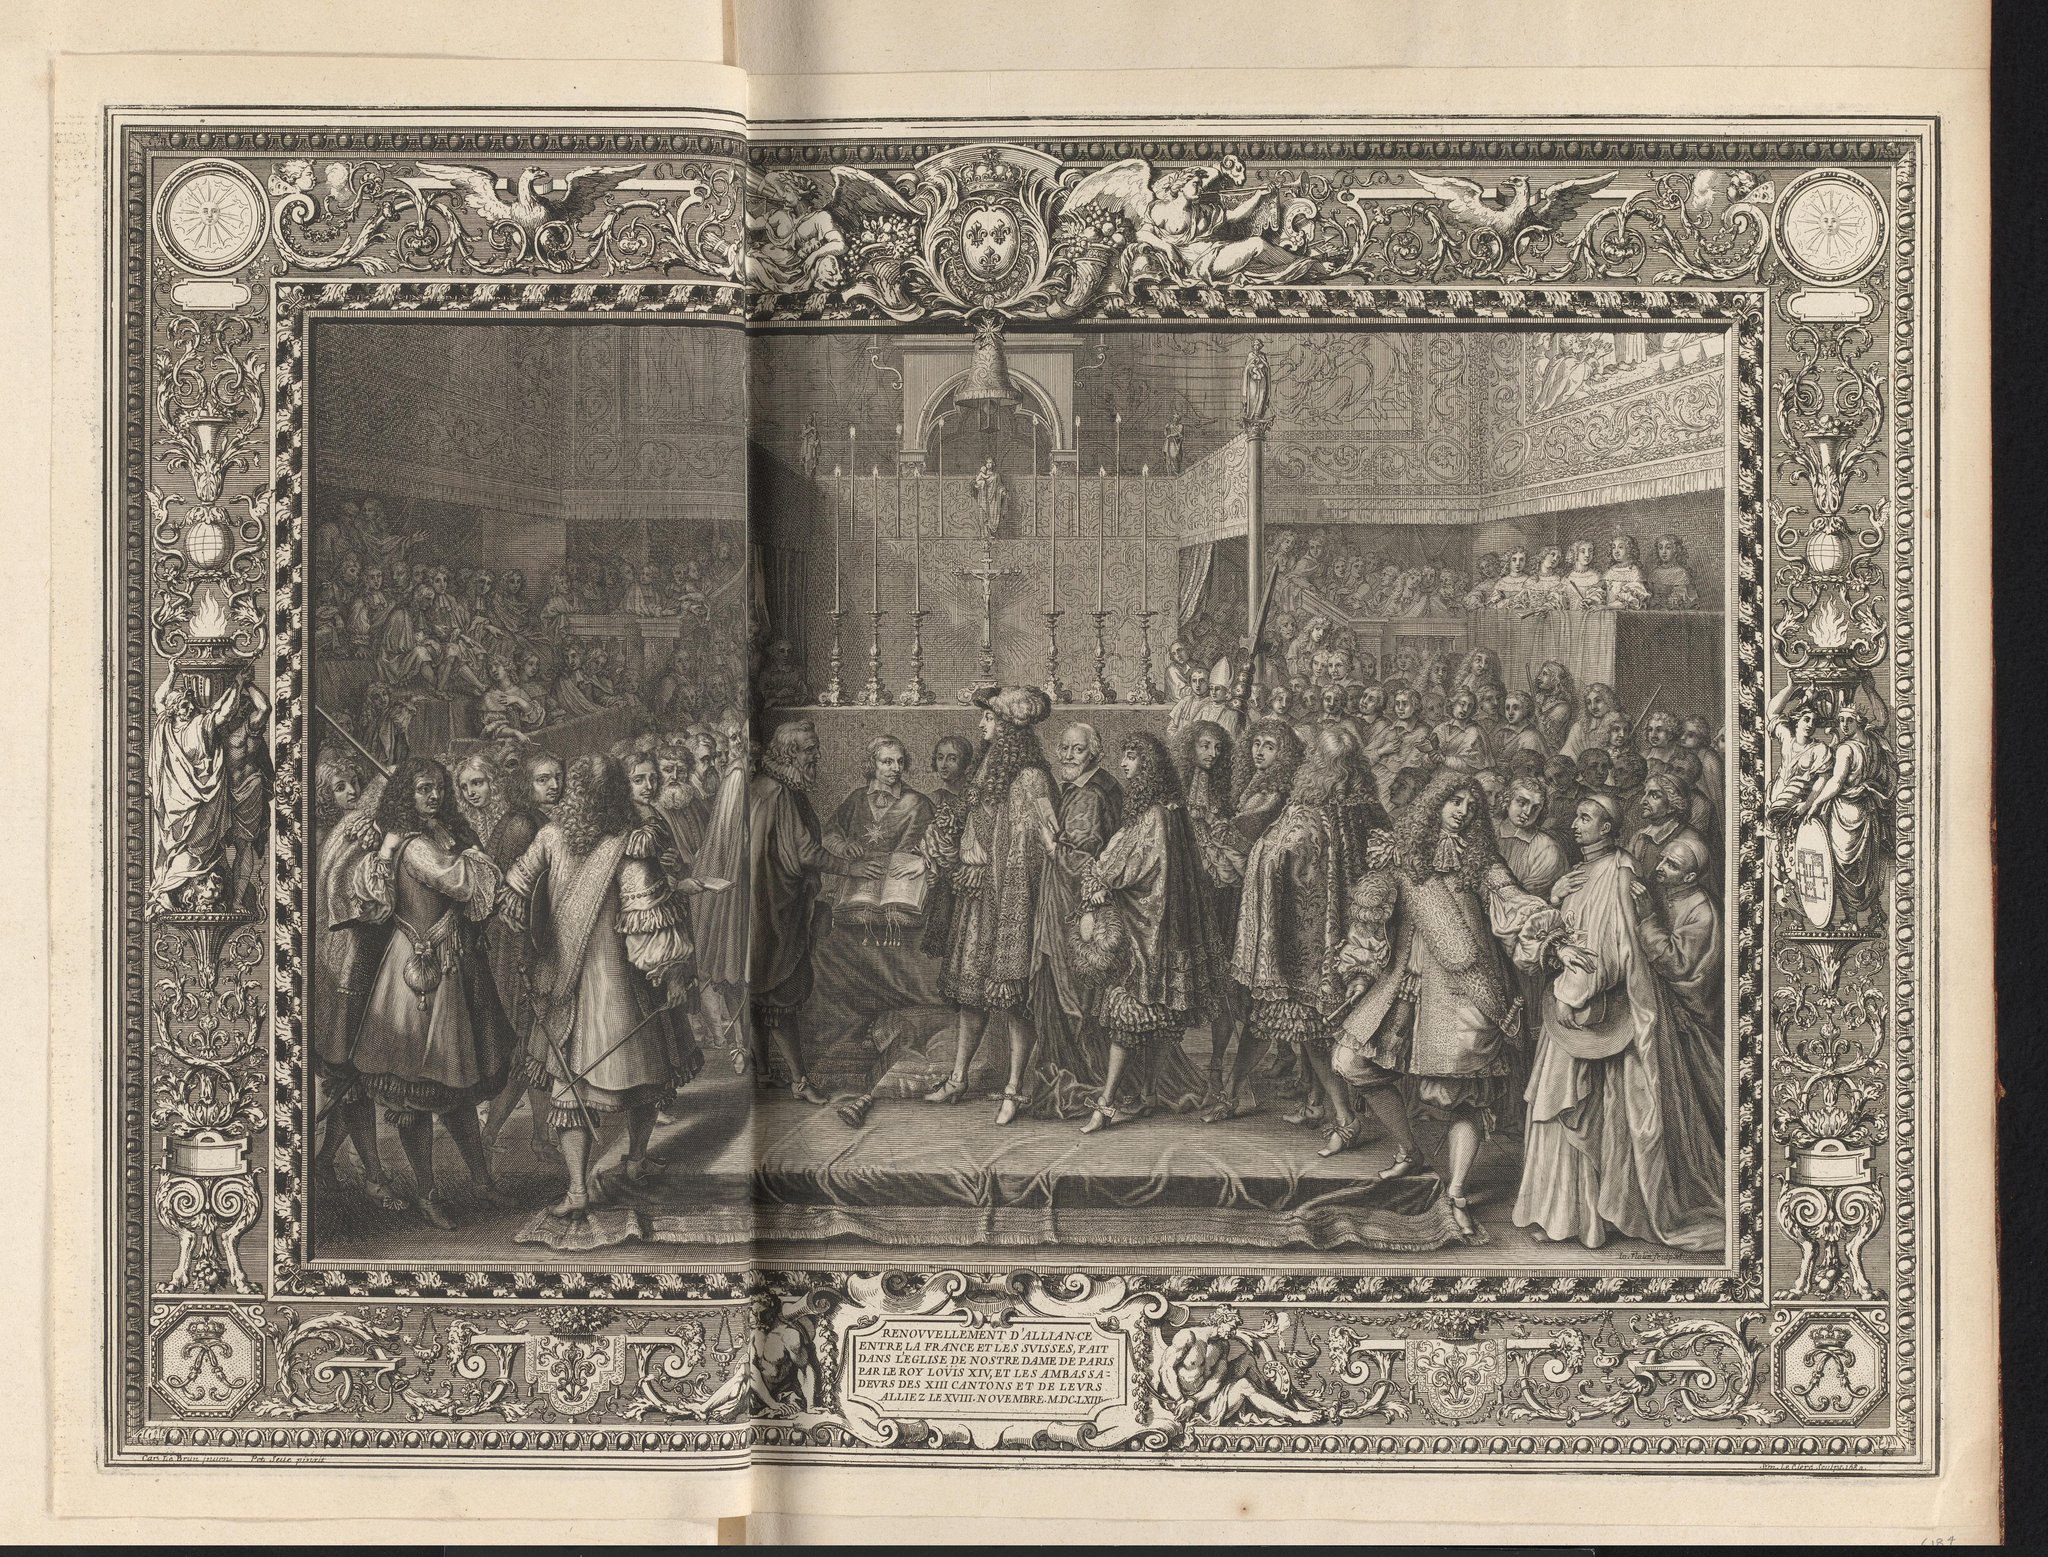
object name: album leaf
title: Tapisseries des grandes conquêtes du Roi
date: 1682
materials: paper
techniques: engraving, etching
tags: lodewijk xiv (koning van frankrijk), rome, clergyman, antonio barberini (ii), cardinal, historical persons, king, alliance, league, union, foedus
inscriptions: date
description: Koning Lodewijk XIV en een Zwitserse ambassadeur leggen hun rechterhand op een bijbel, vastgehouden door kardinaal Barberini. Prent maakt deel uit van een album.